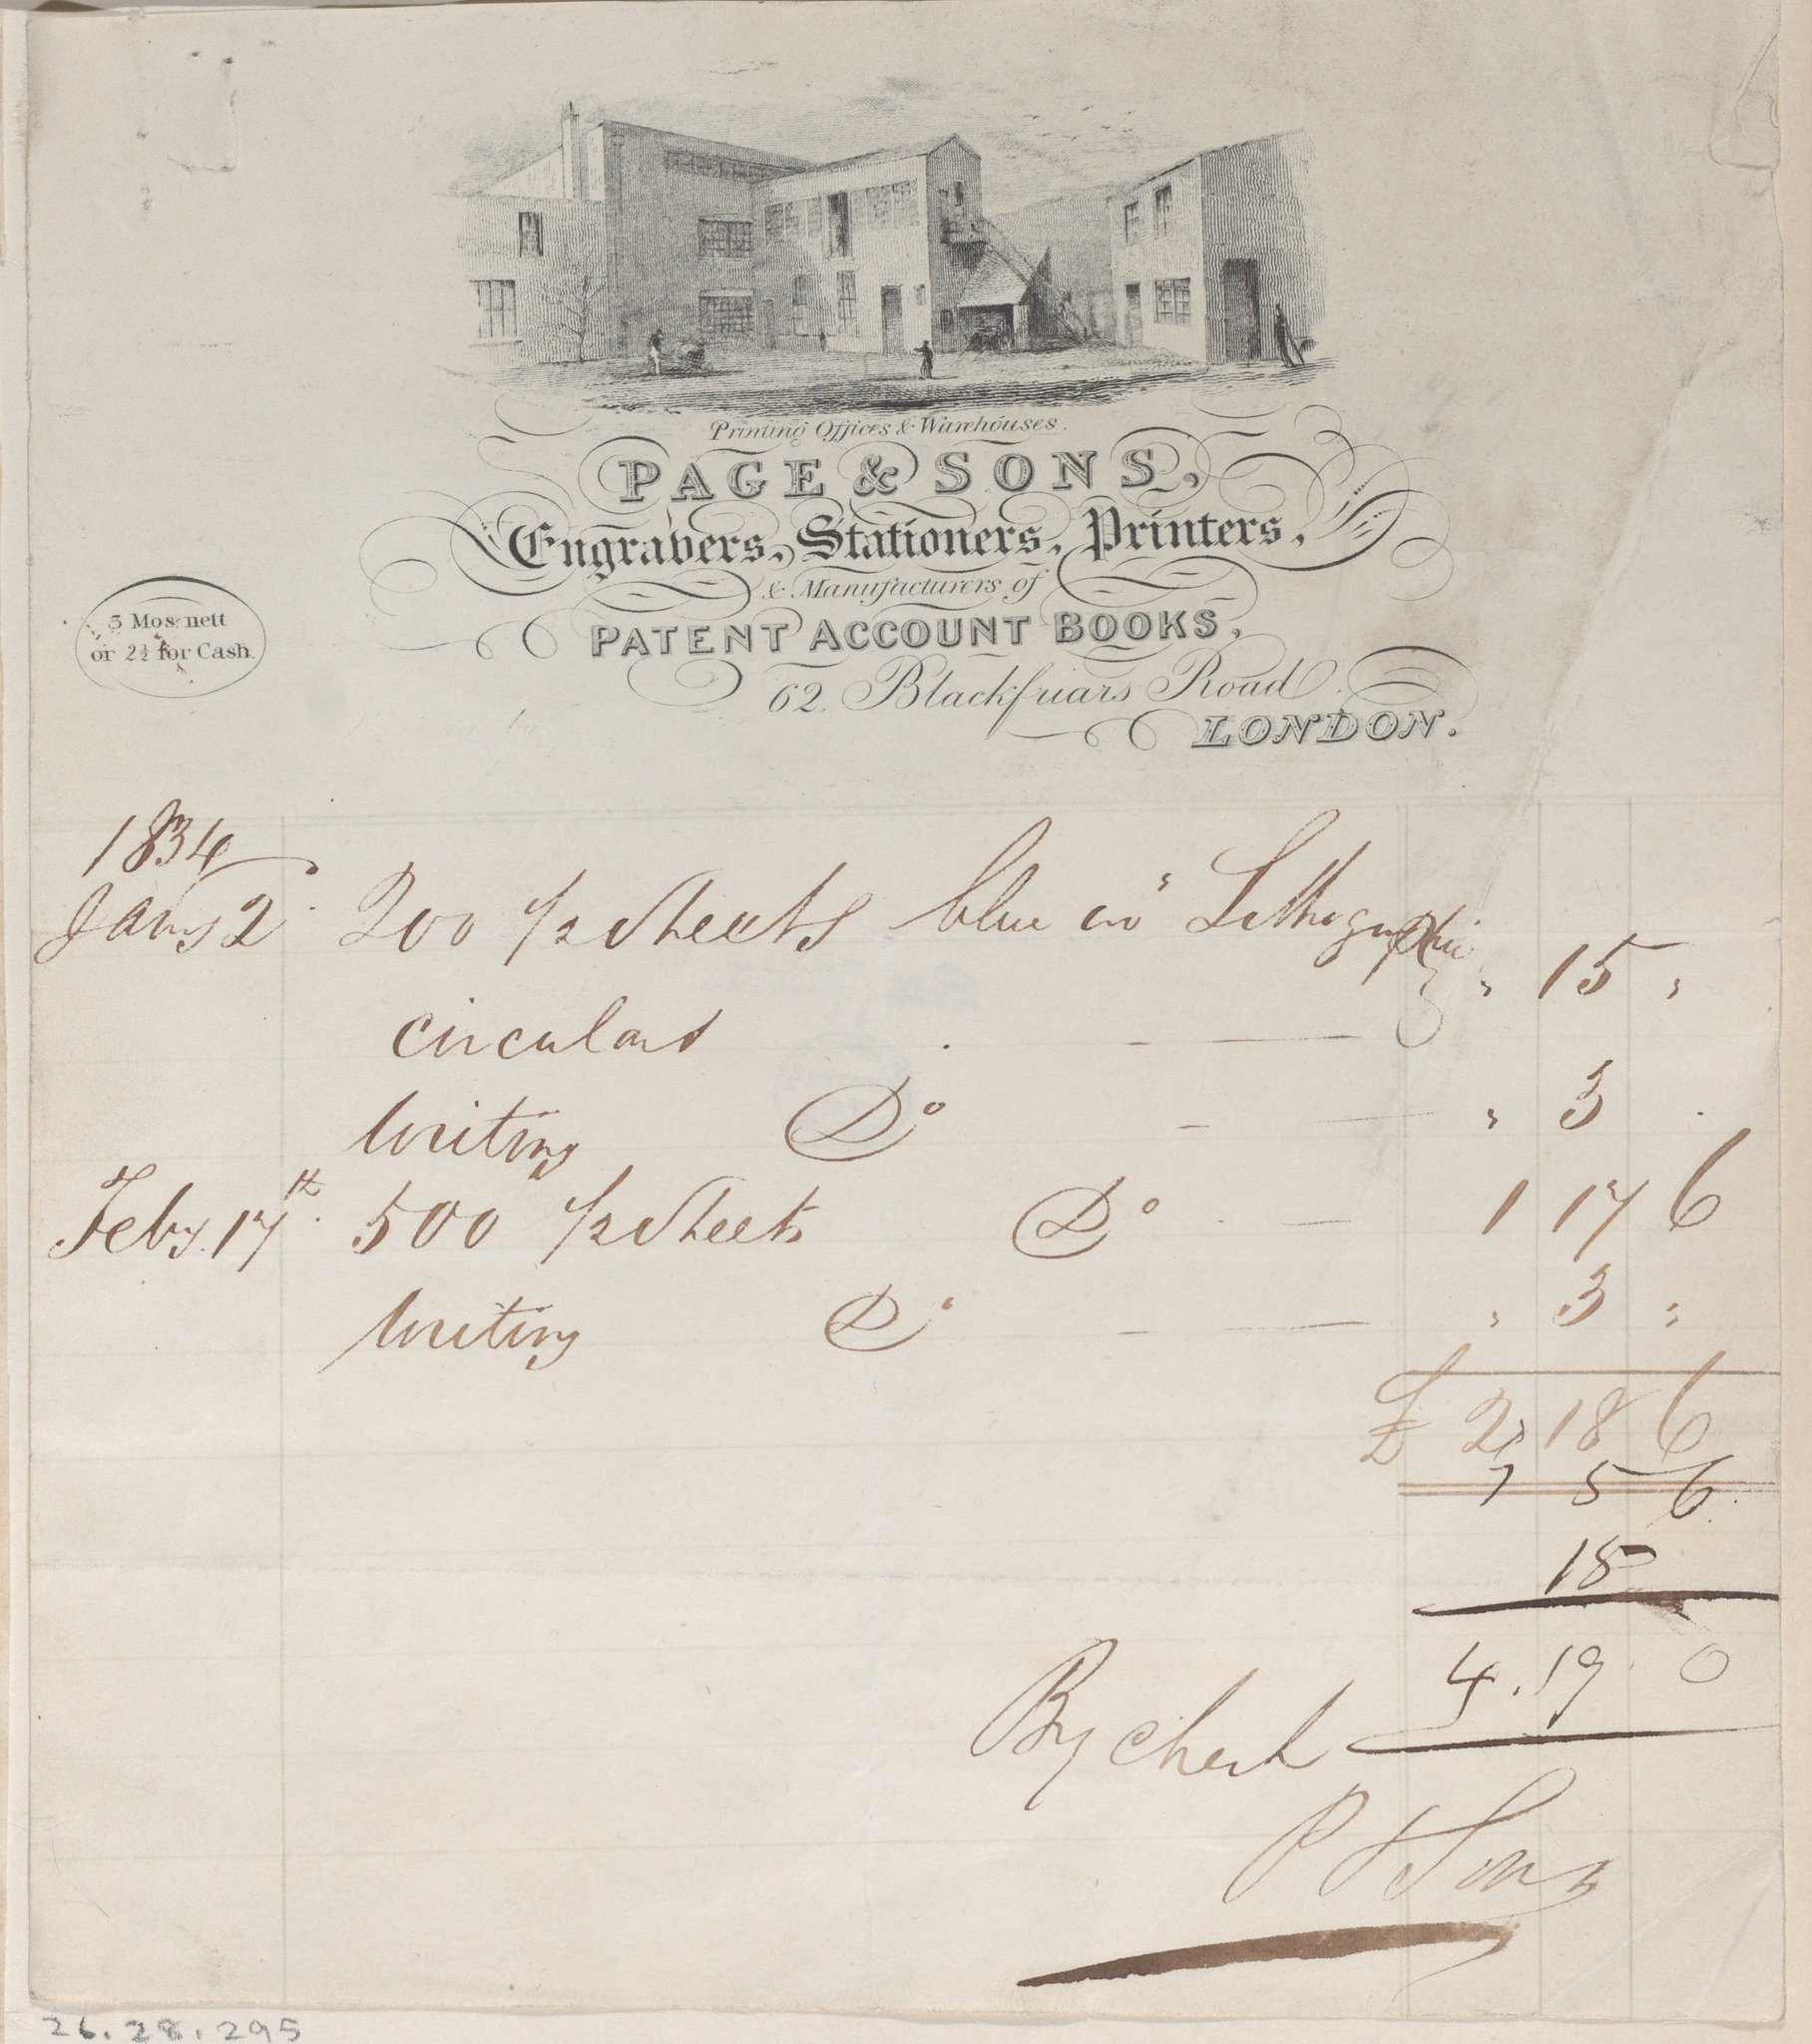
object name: print, trade card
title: Trade Card for Page & Sons, Engravers, Stationers & Printers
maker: anonymous, british, 19th century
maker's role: artist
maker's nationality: british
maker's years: 1800-1900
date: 1801-1900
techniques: engraving